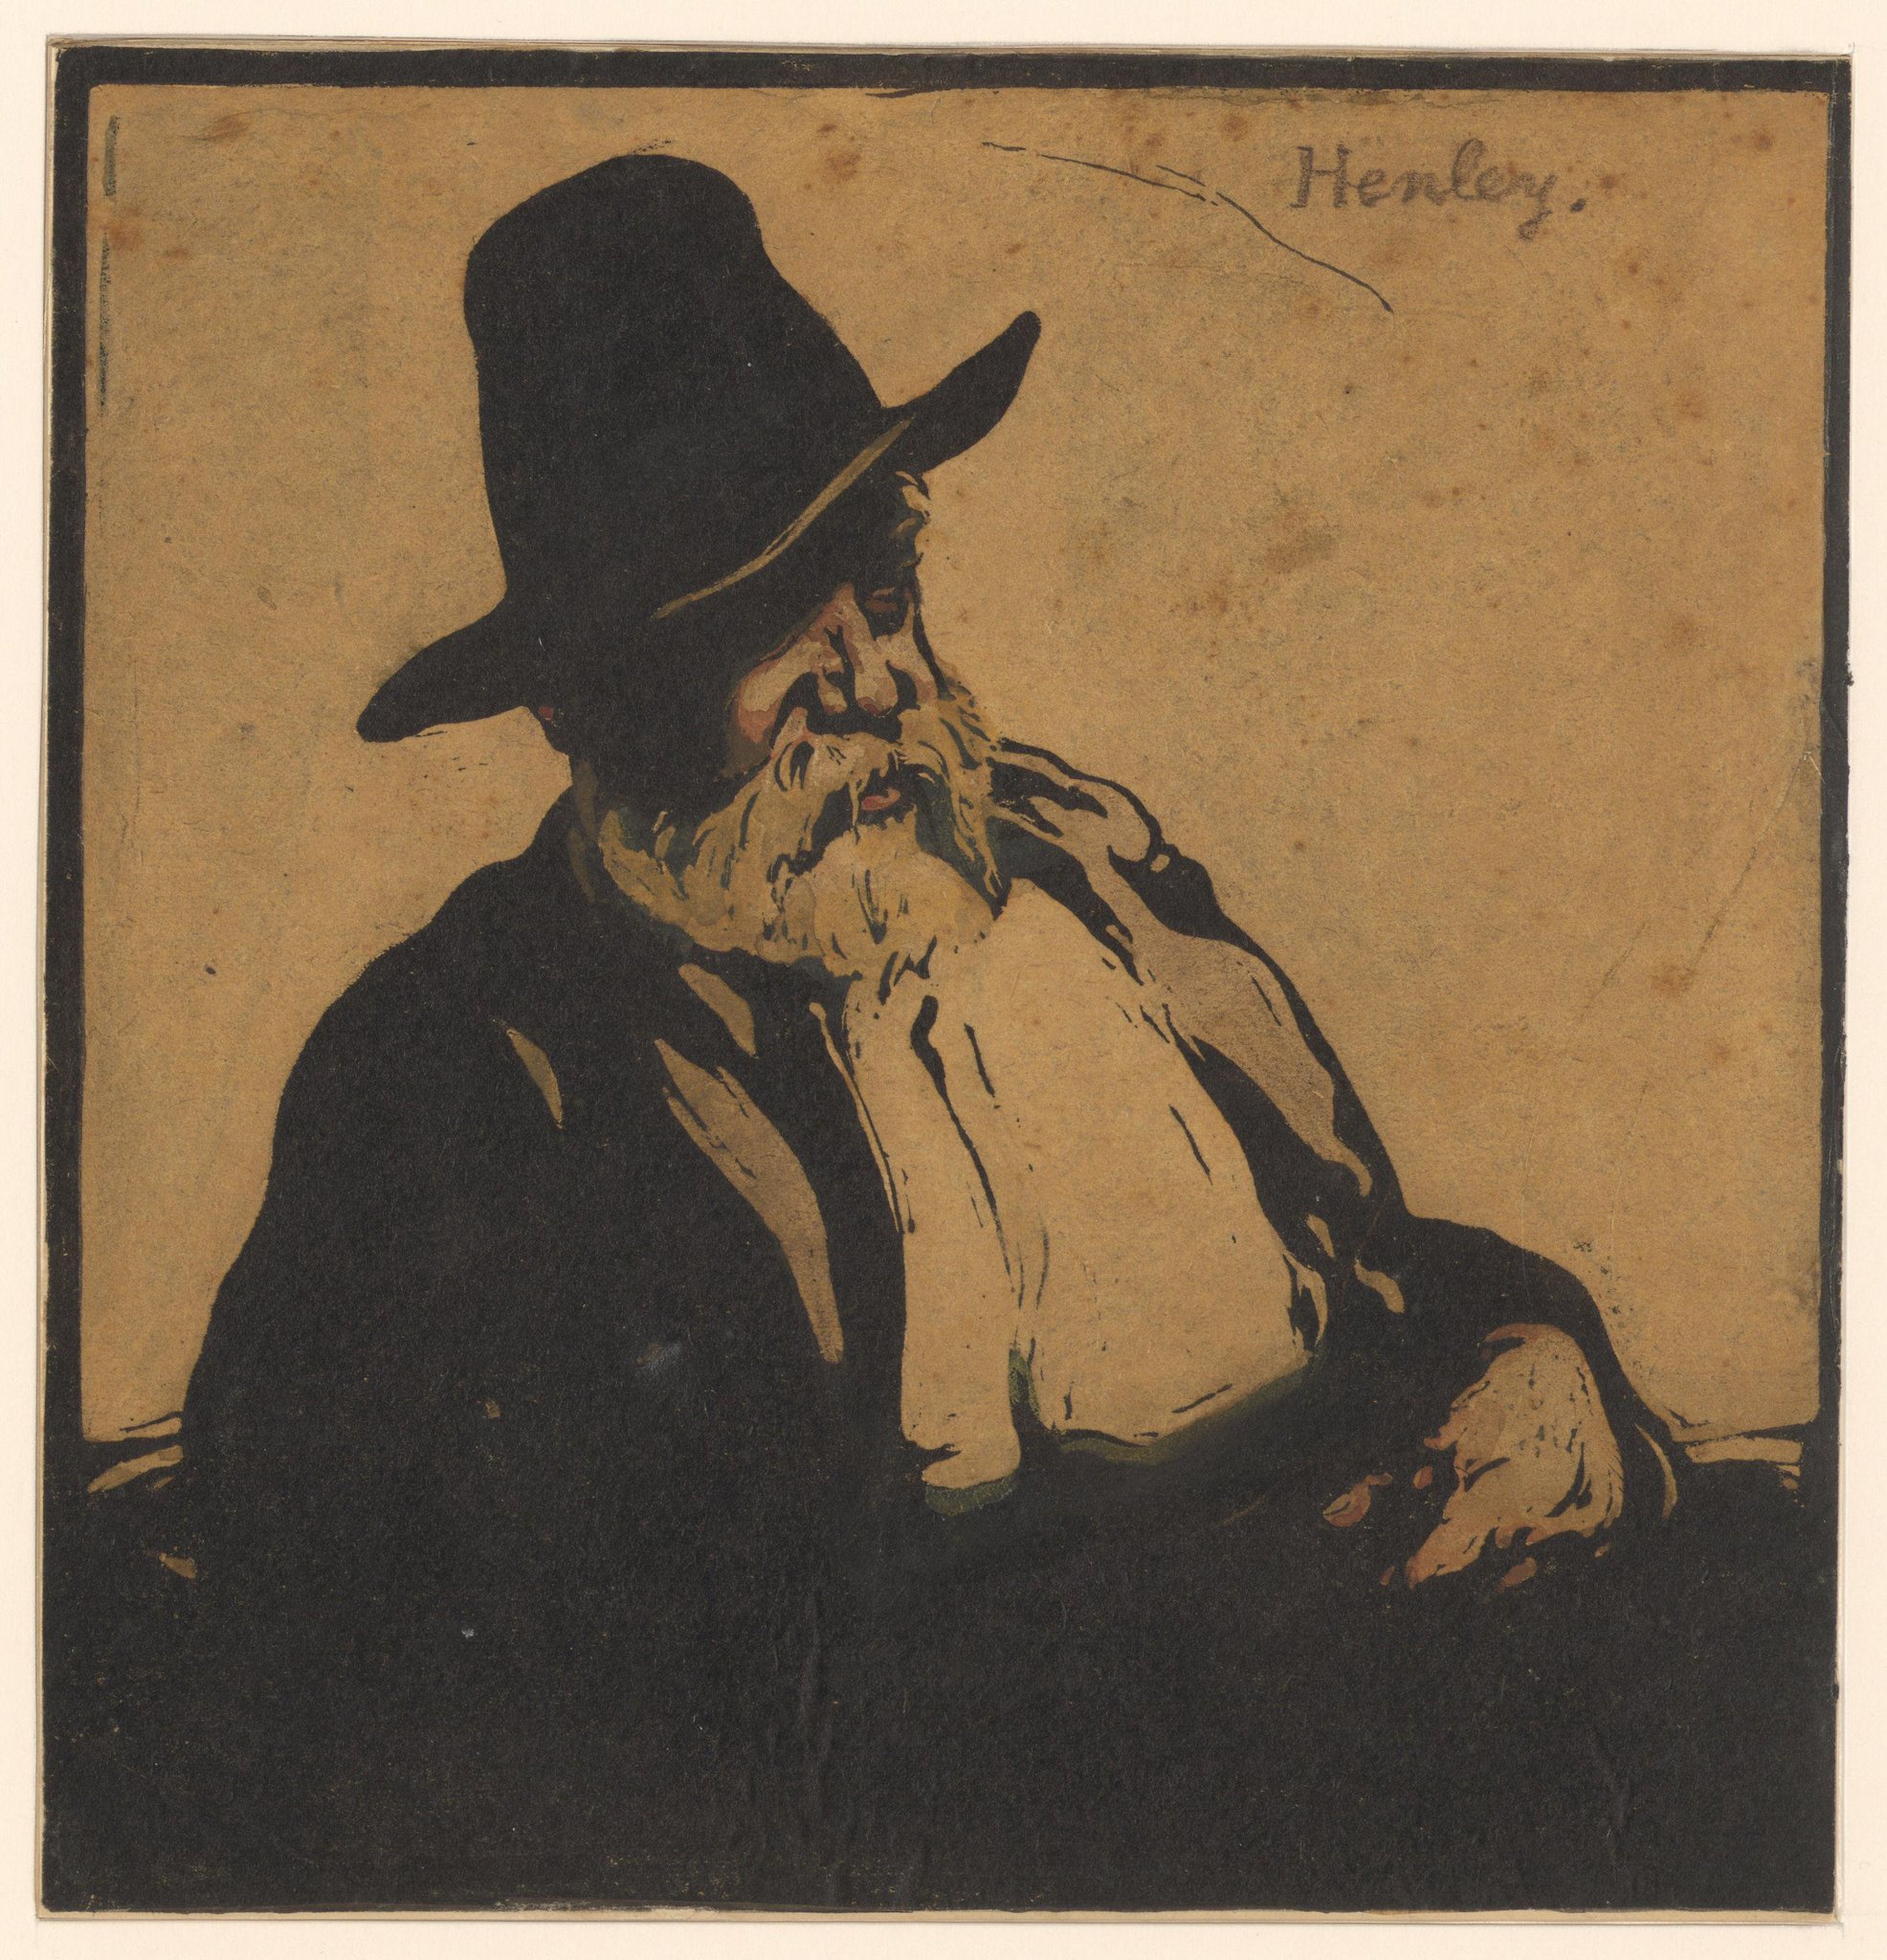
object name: print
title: Portret van William Ernest Henley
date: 1901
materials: cardboard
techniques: hand coloring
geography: england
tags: william ernest henley, head-gear, historical persons, portrait of a writer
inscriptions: collector's mark: Lugt 2228, inscription: ‘b[2]139’, collector's mark: Lugt 2760, inscription: ‘Henley’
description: Het portret was oorspronkelijk bestemd voor de tweede reeks 'Twelve Portraits' uitgegeven in 1902, maar werd om onbekende redenen niet opgenomen. Henley schreef de kwatrijnen voor Nicholson's in 1898 verschenen album 'London Types'.